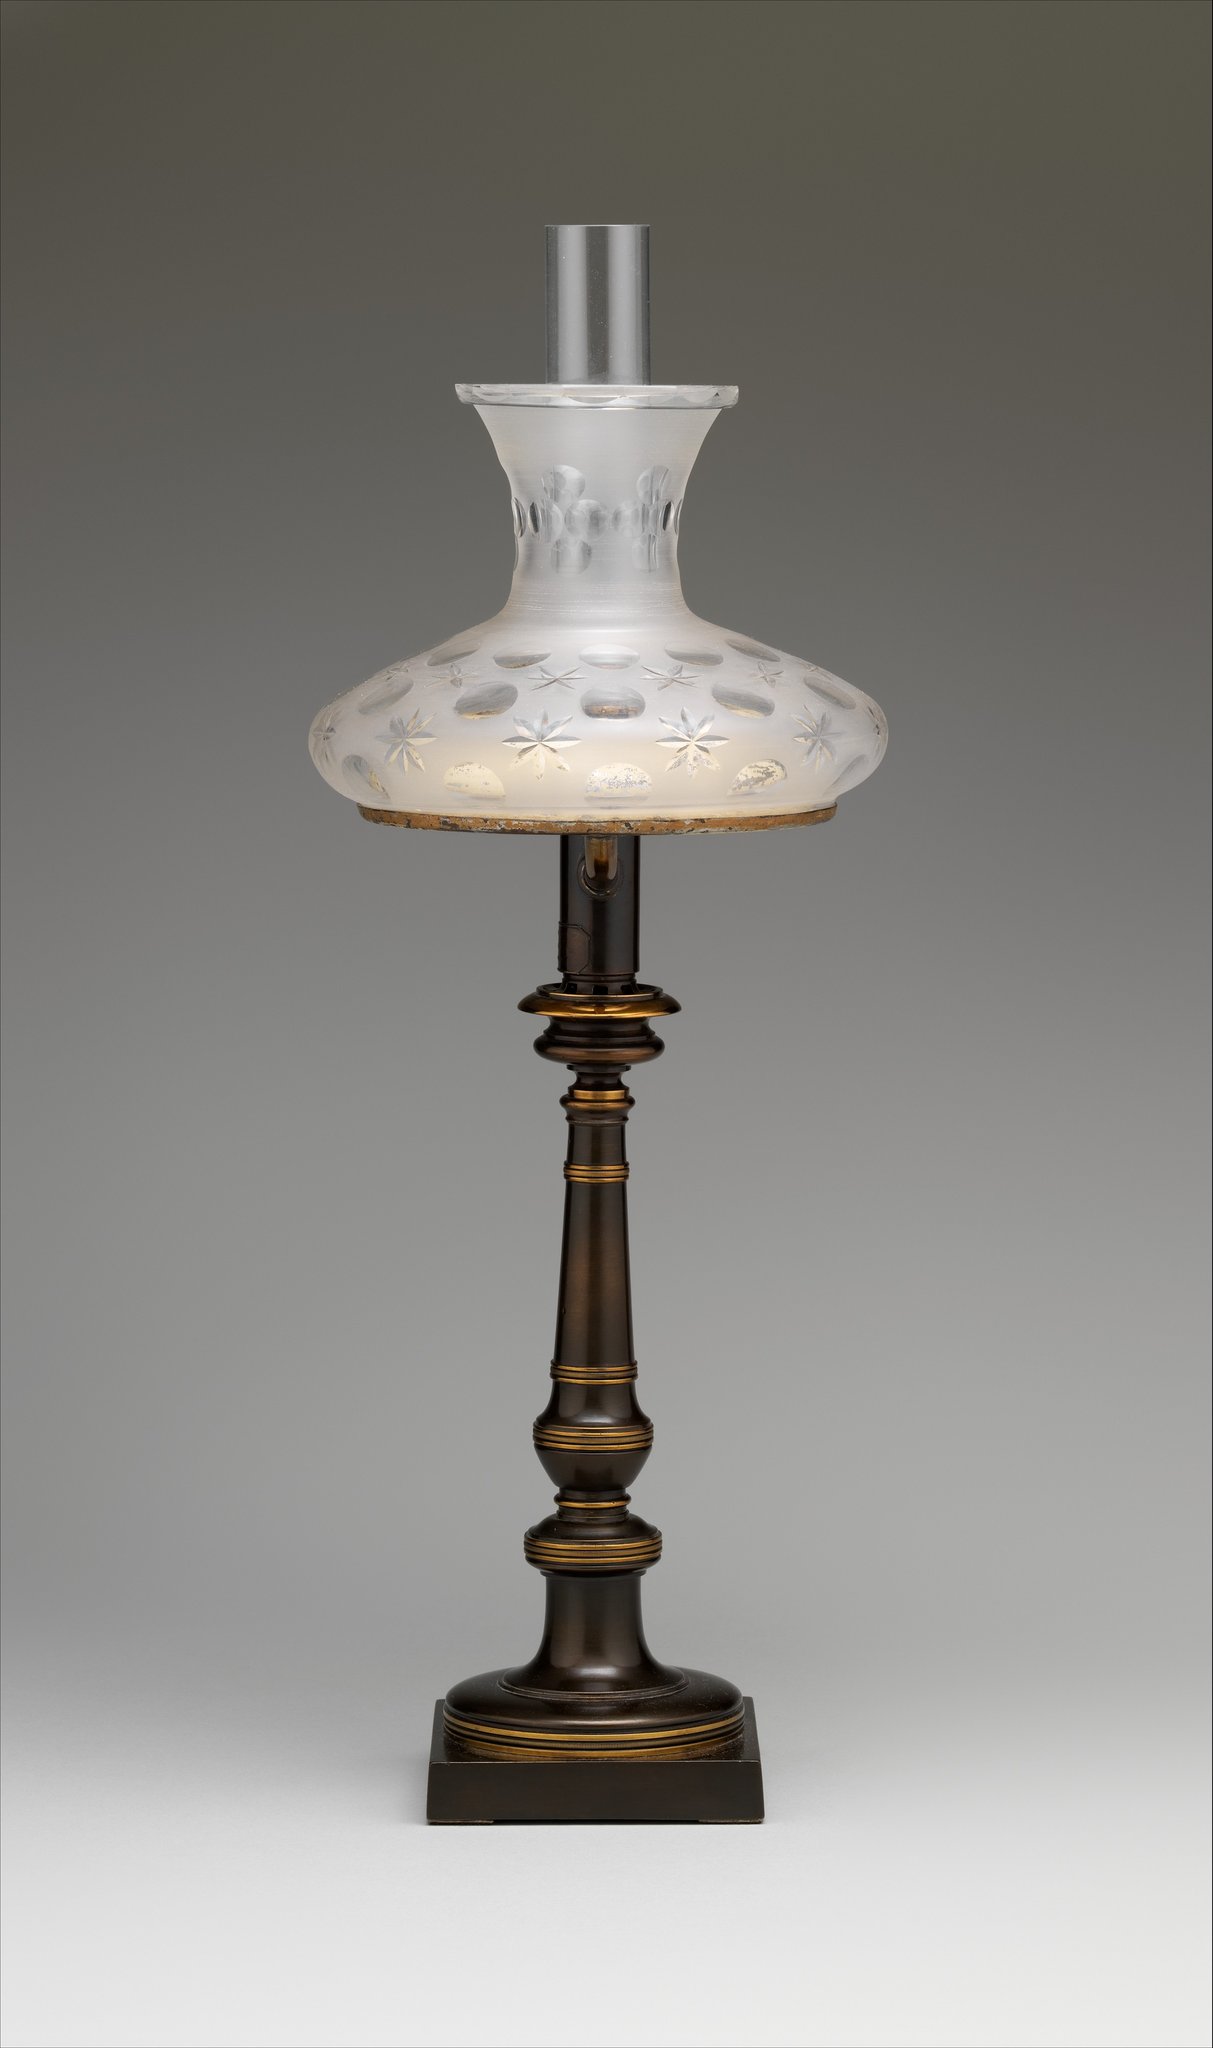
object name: lamp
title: Sinumbra lamp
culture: american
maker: william carleton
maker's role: maker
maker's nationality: american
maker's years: 1797-1876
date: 1835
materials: brass, glass, steel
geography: united states